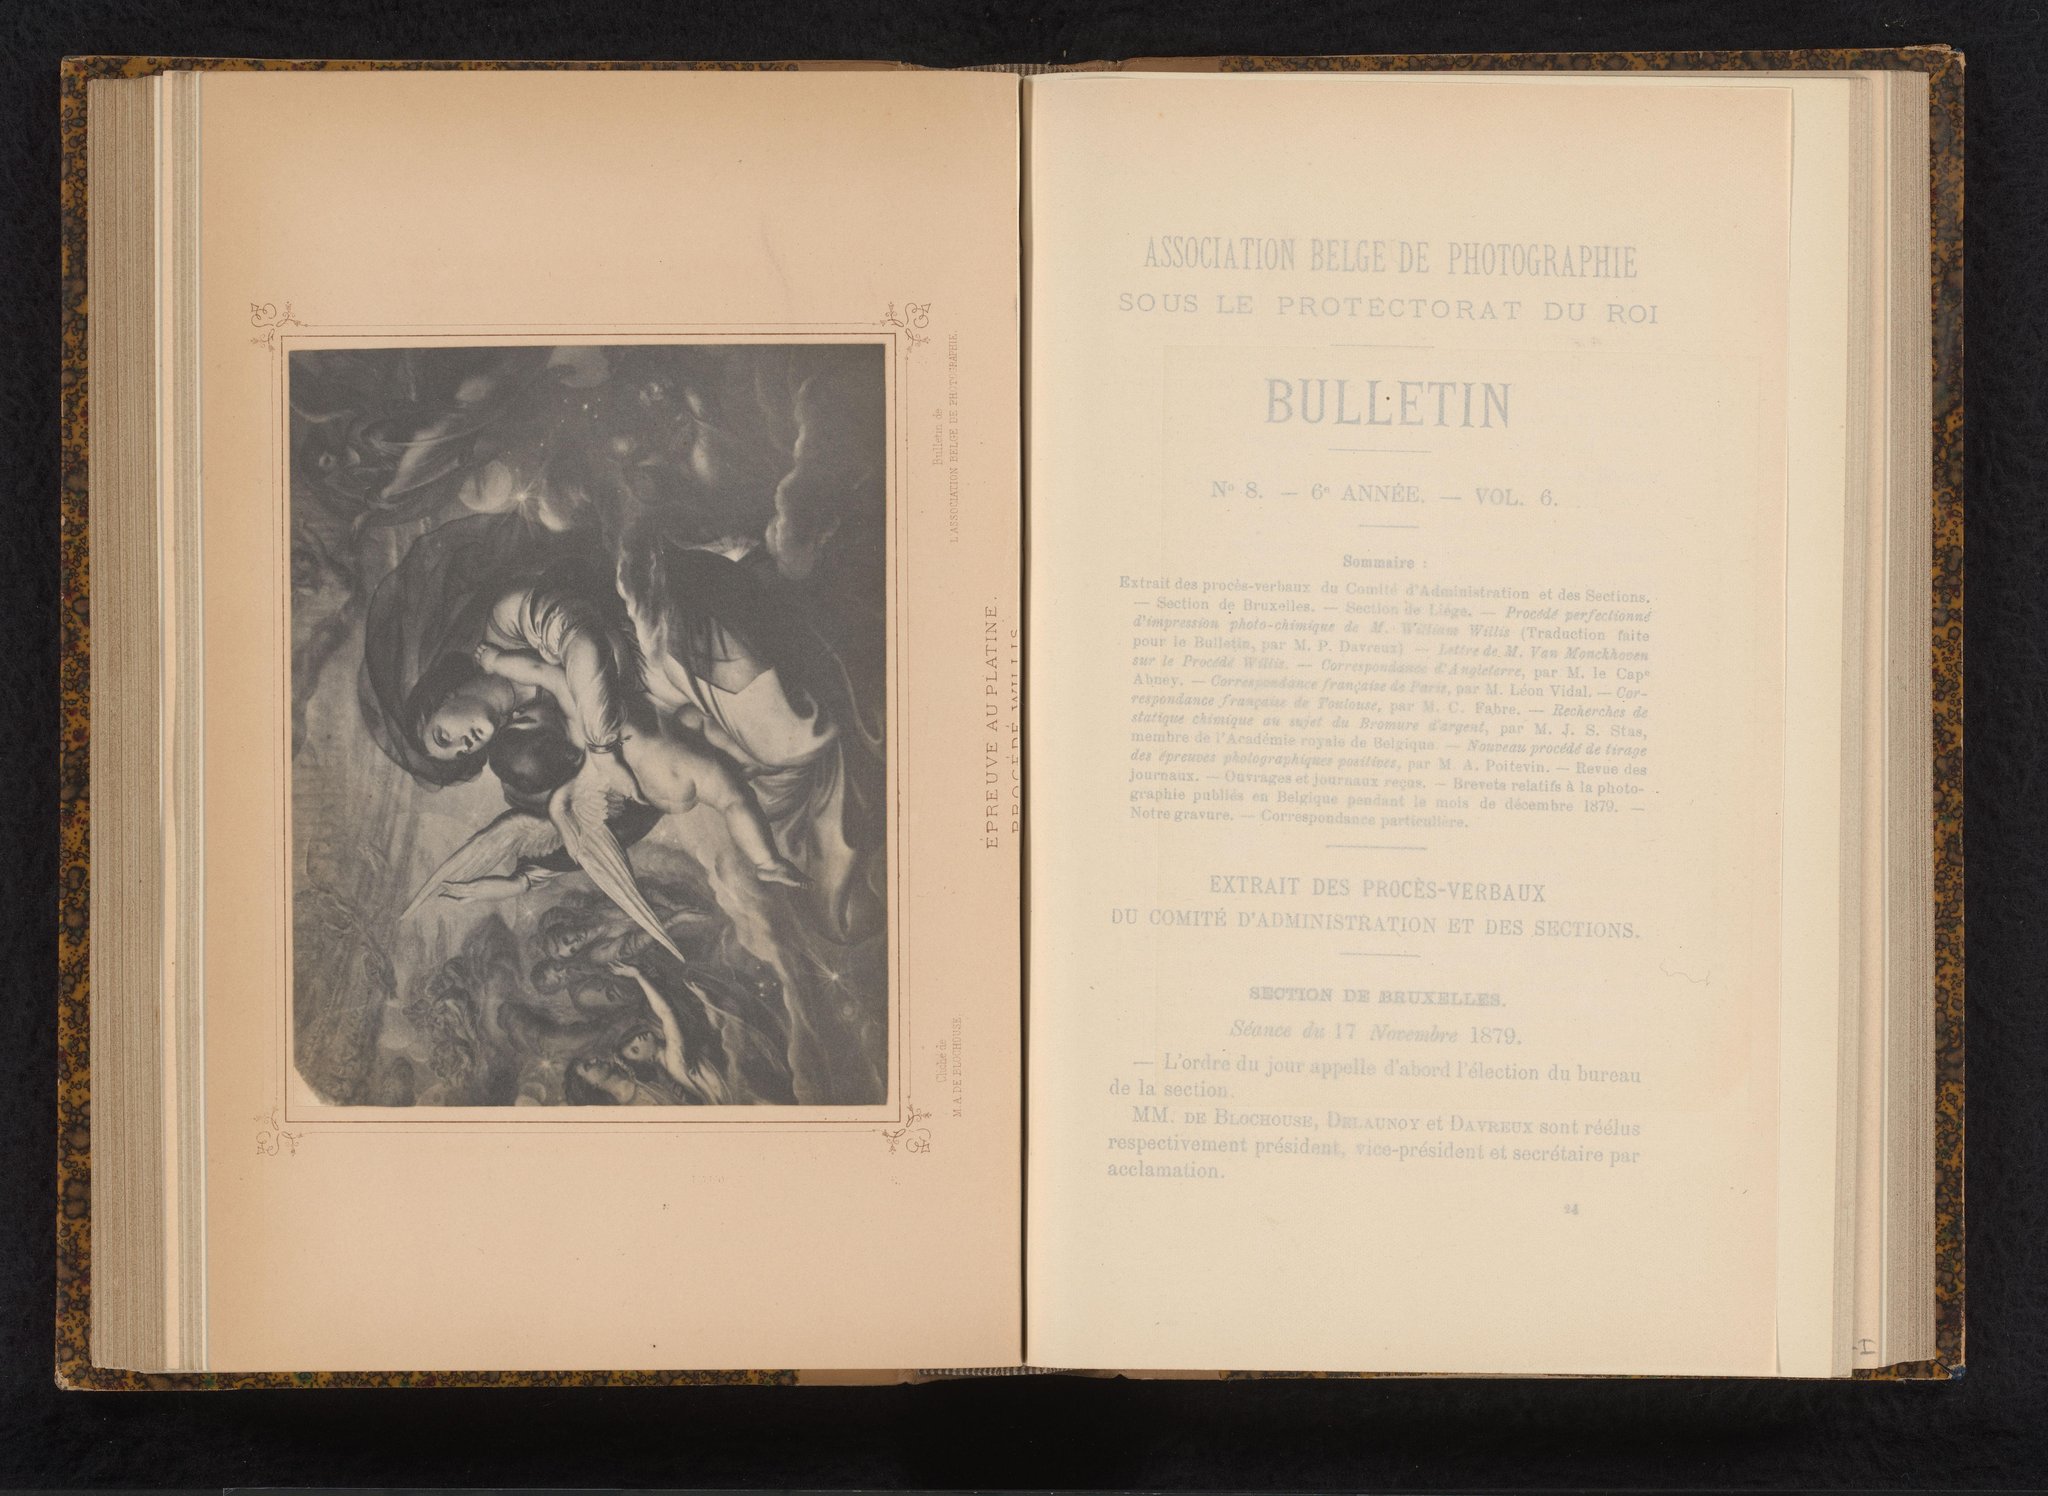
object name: page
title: Fotoreproductie van een schilderij van een vrouwelijke heilige met een engel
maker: alexandre de blochouse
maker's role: fotograaf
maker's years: 1821-1901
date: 1879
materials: cardboard, paper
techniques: platinum process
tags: female saints, angels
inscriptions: inscription: ‘Épreuve au platine./ Procédé Willis’